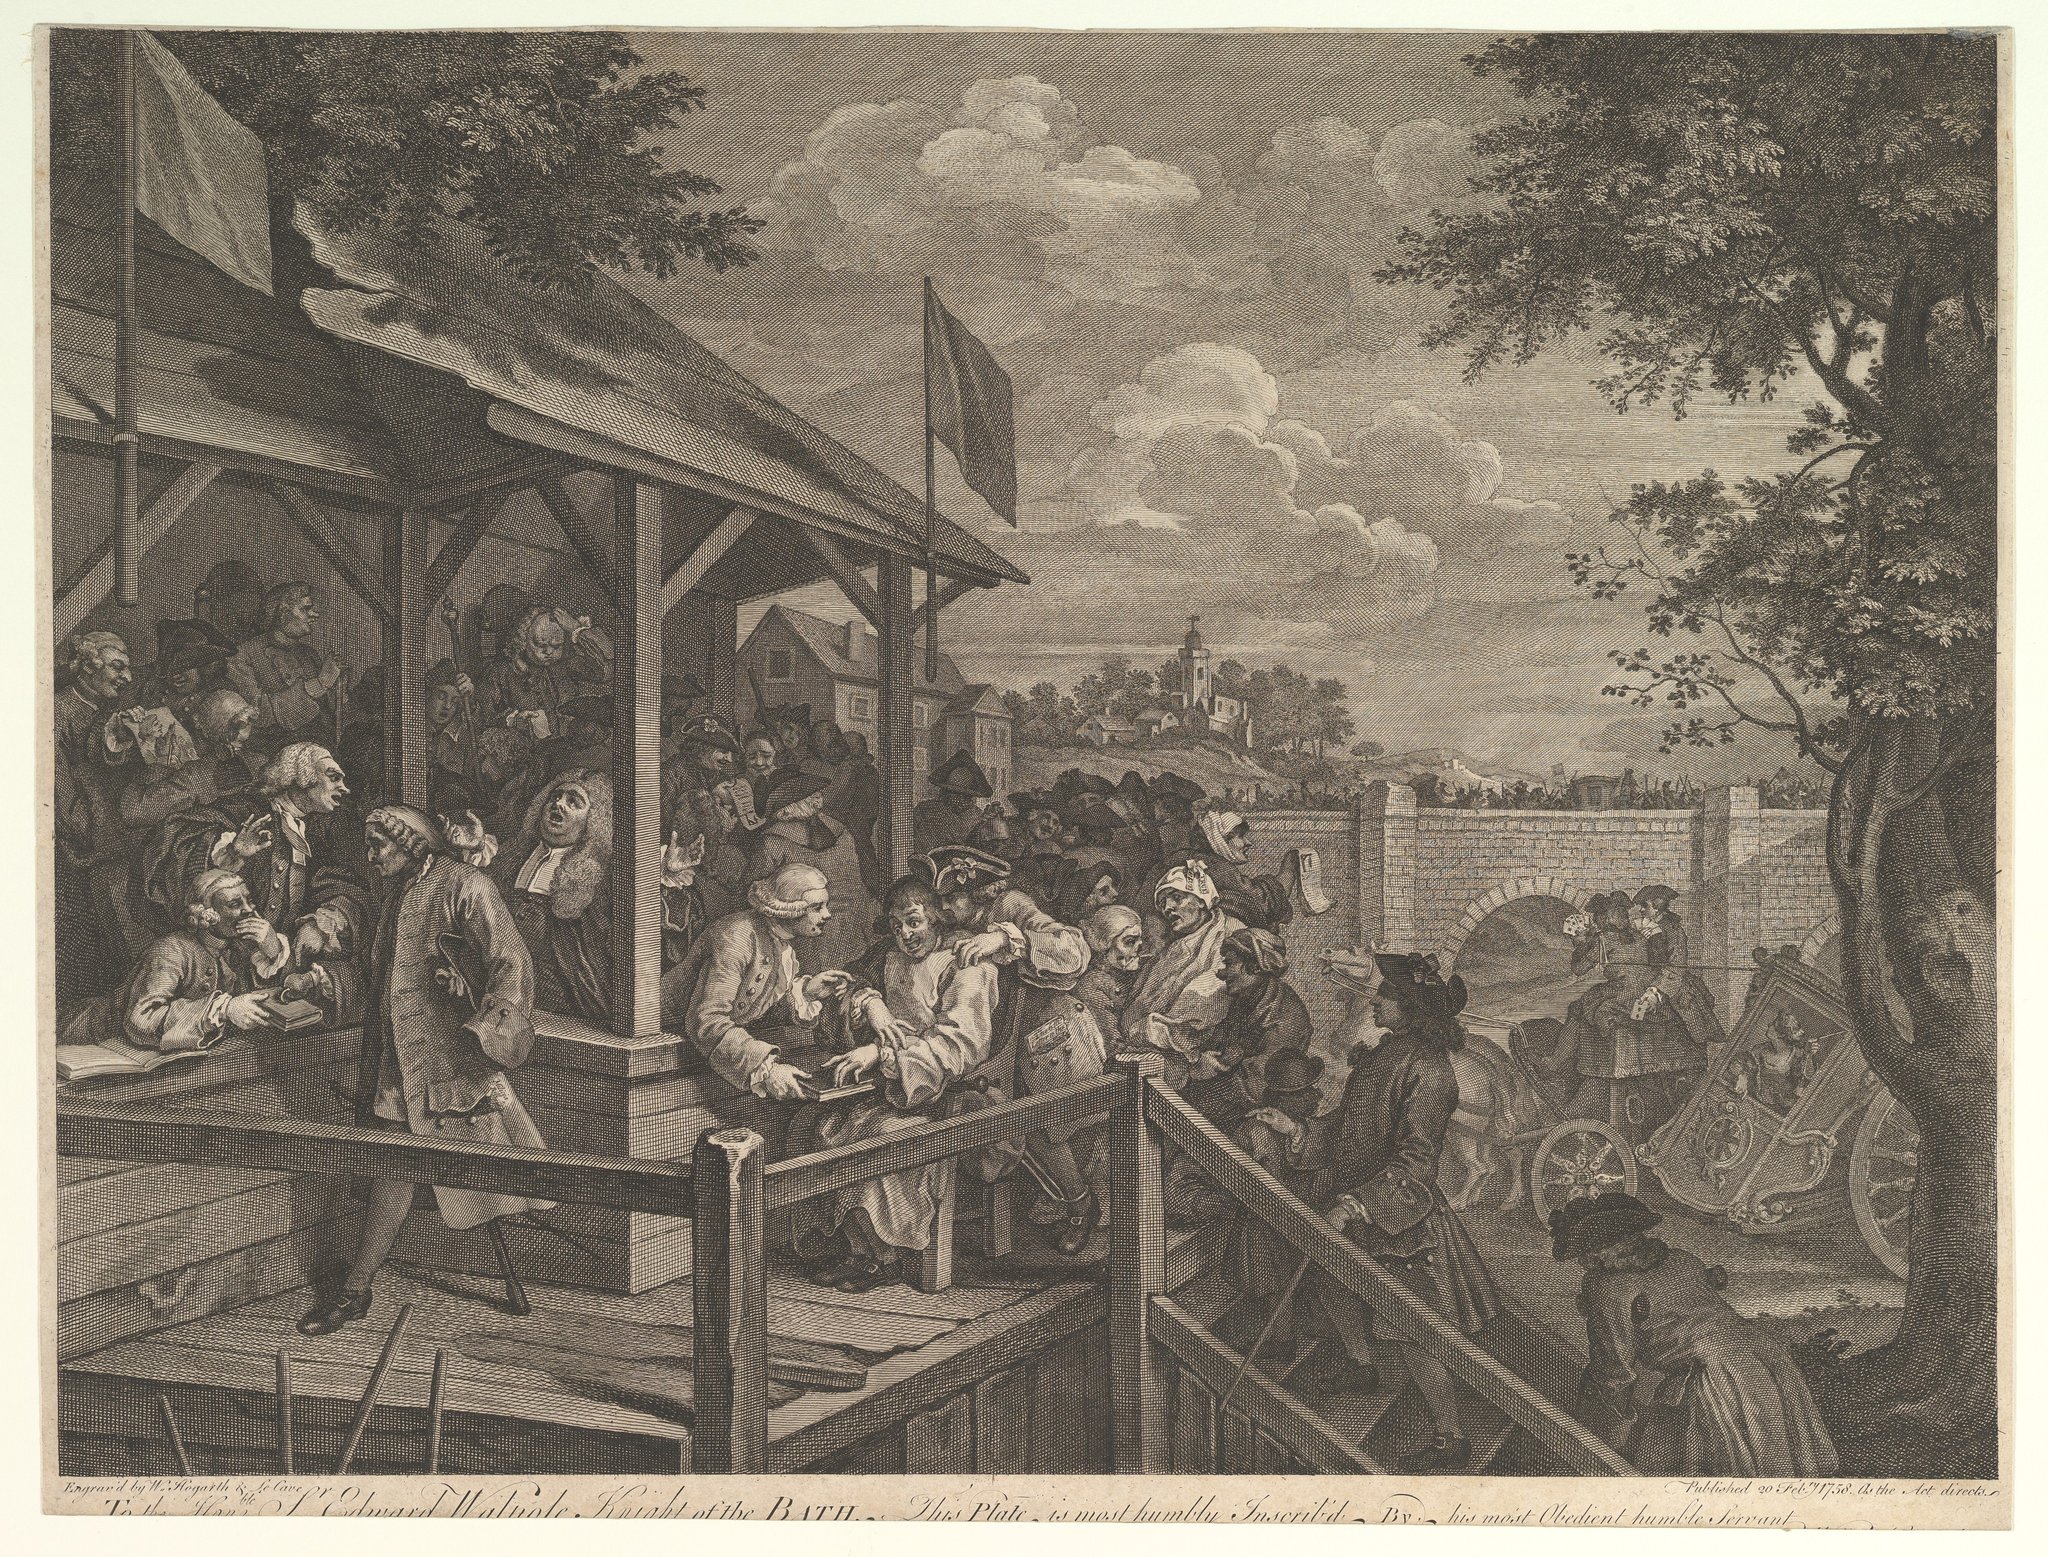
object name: print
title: The Polling, Plate III: Four Prints of an Election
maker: william hogarth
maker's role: artist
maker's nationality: british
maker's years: 1697-1764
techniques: engraving, etching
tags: elections,crowd,flags